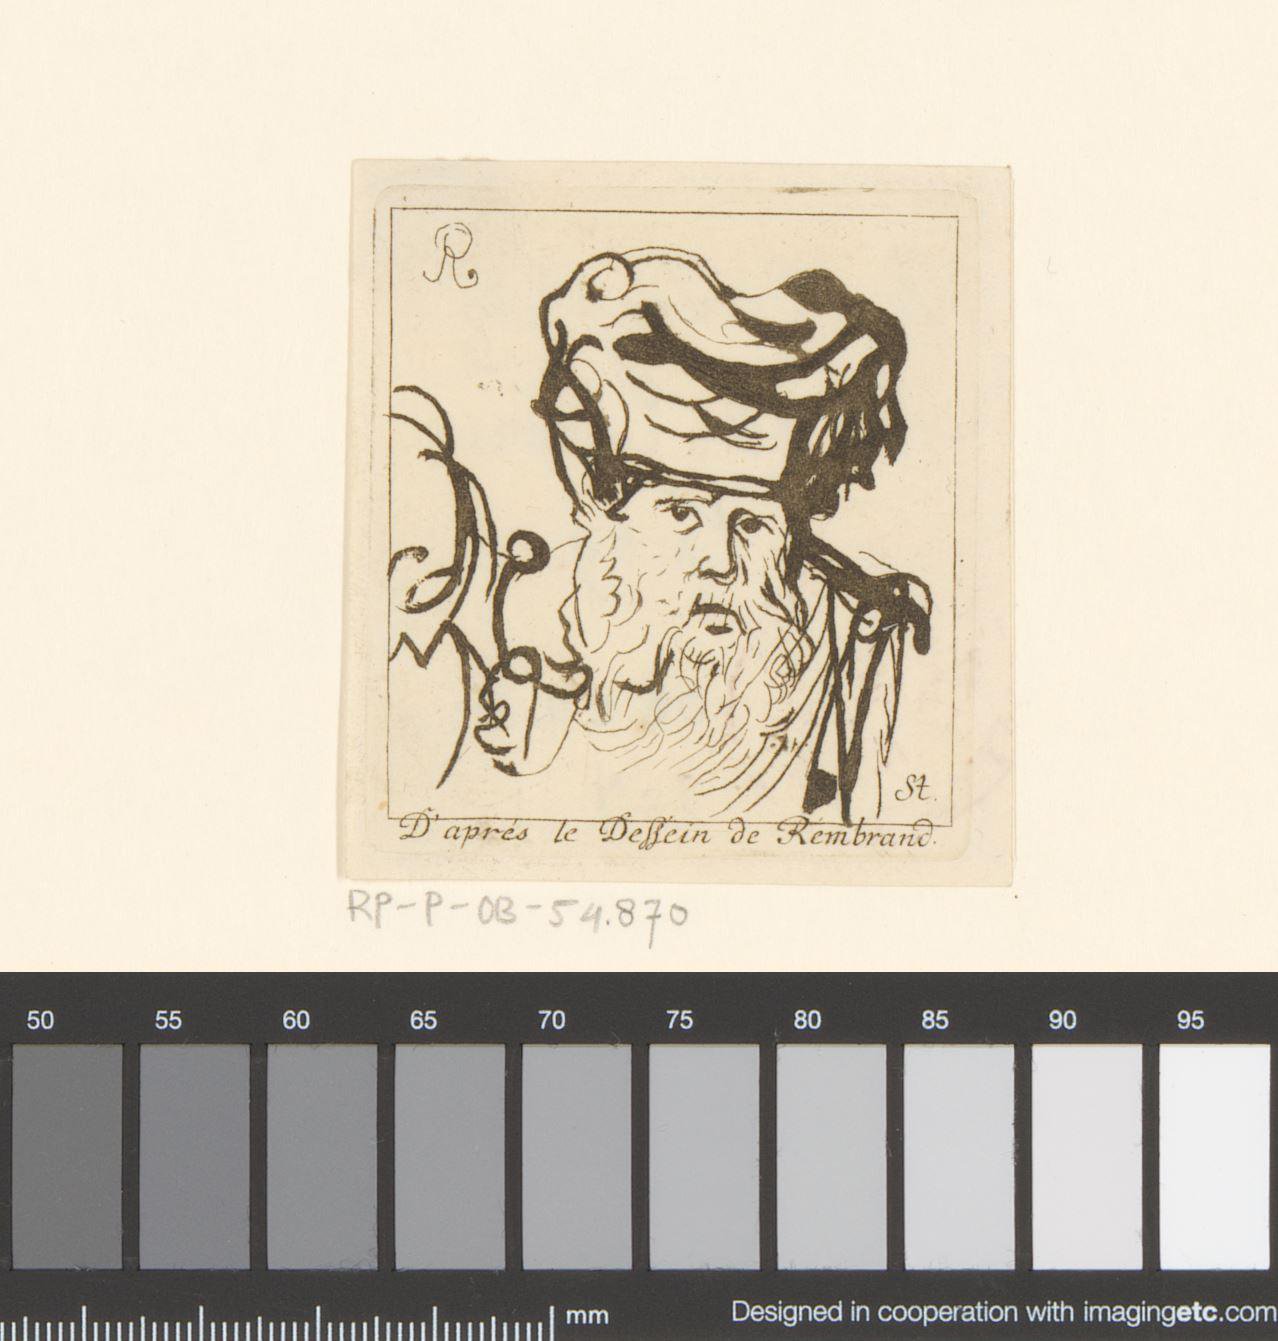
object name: print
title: Bebaarde man met muts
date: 1737-1787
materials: paper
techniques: etching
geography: germany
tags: head-gear: cap (+ men's clothes), old man, beard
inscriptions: collector's mark: Lugt 240